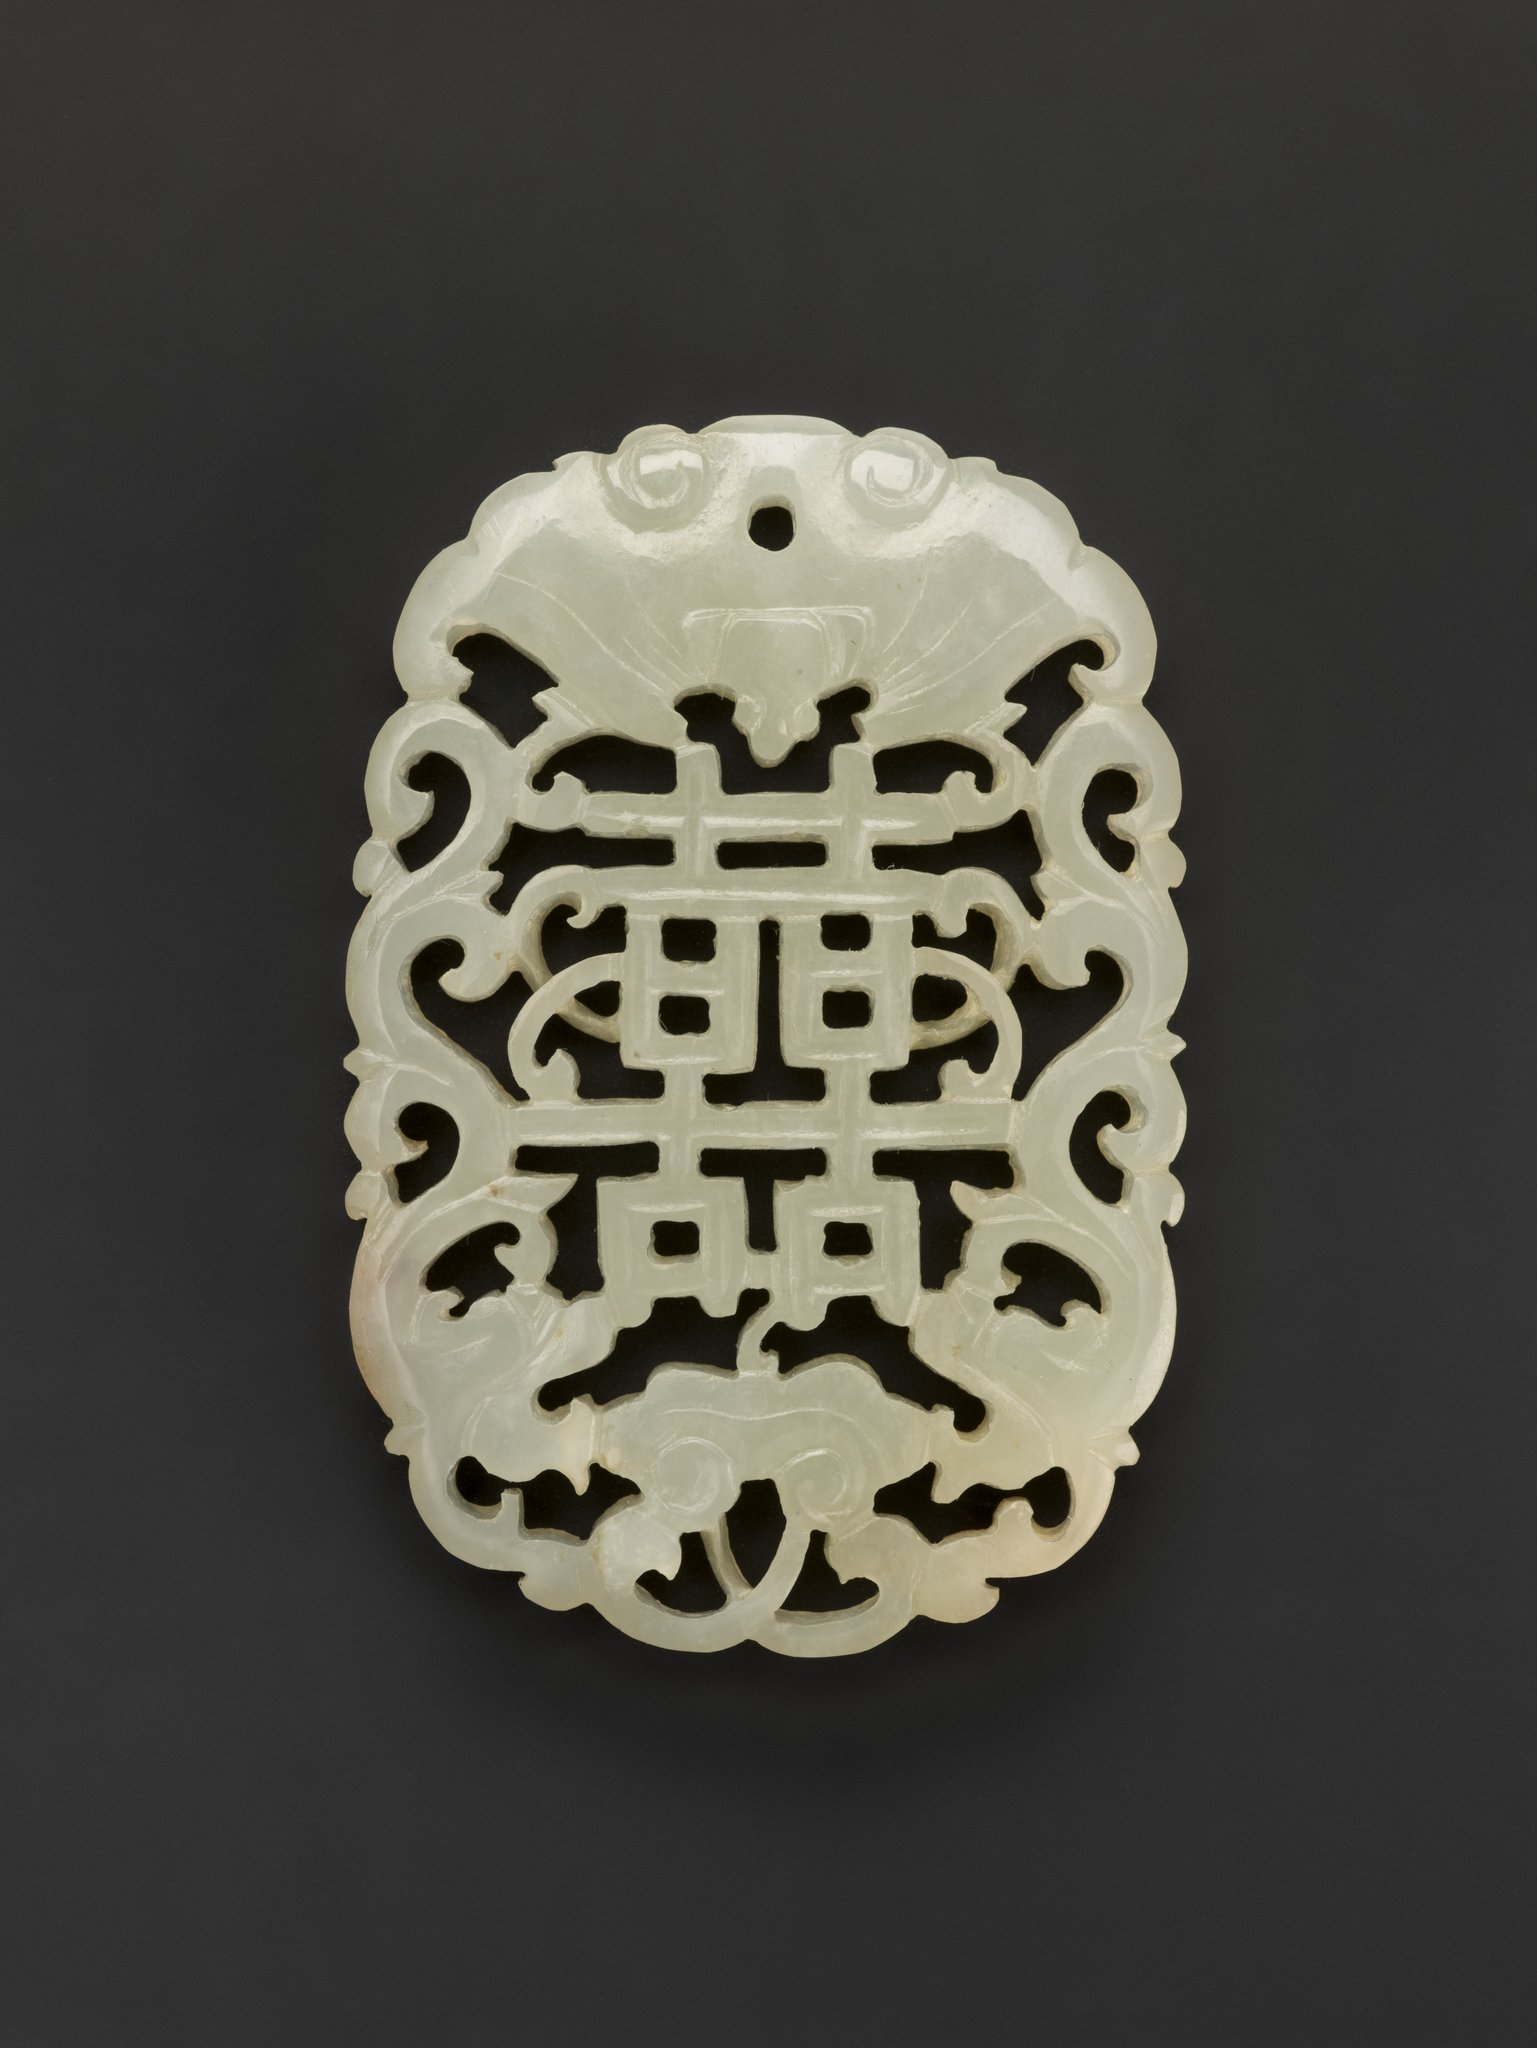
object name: pendant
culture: chinese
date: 1736-1795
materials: jade